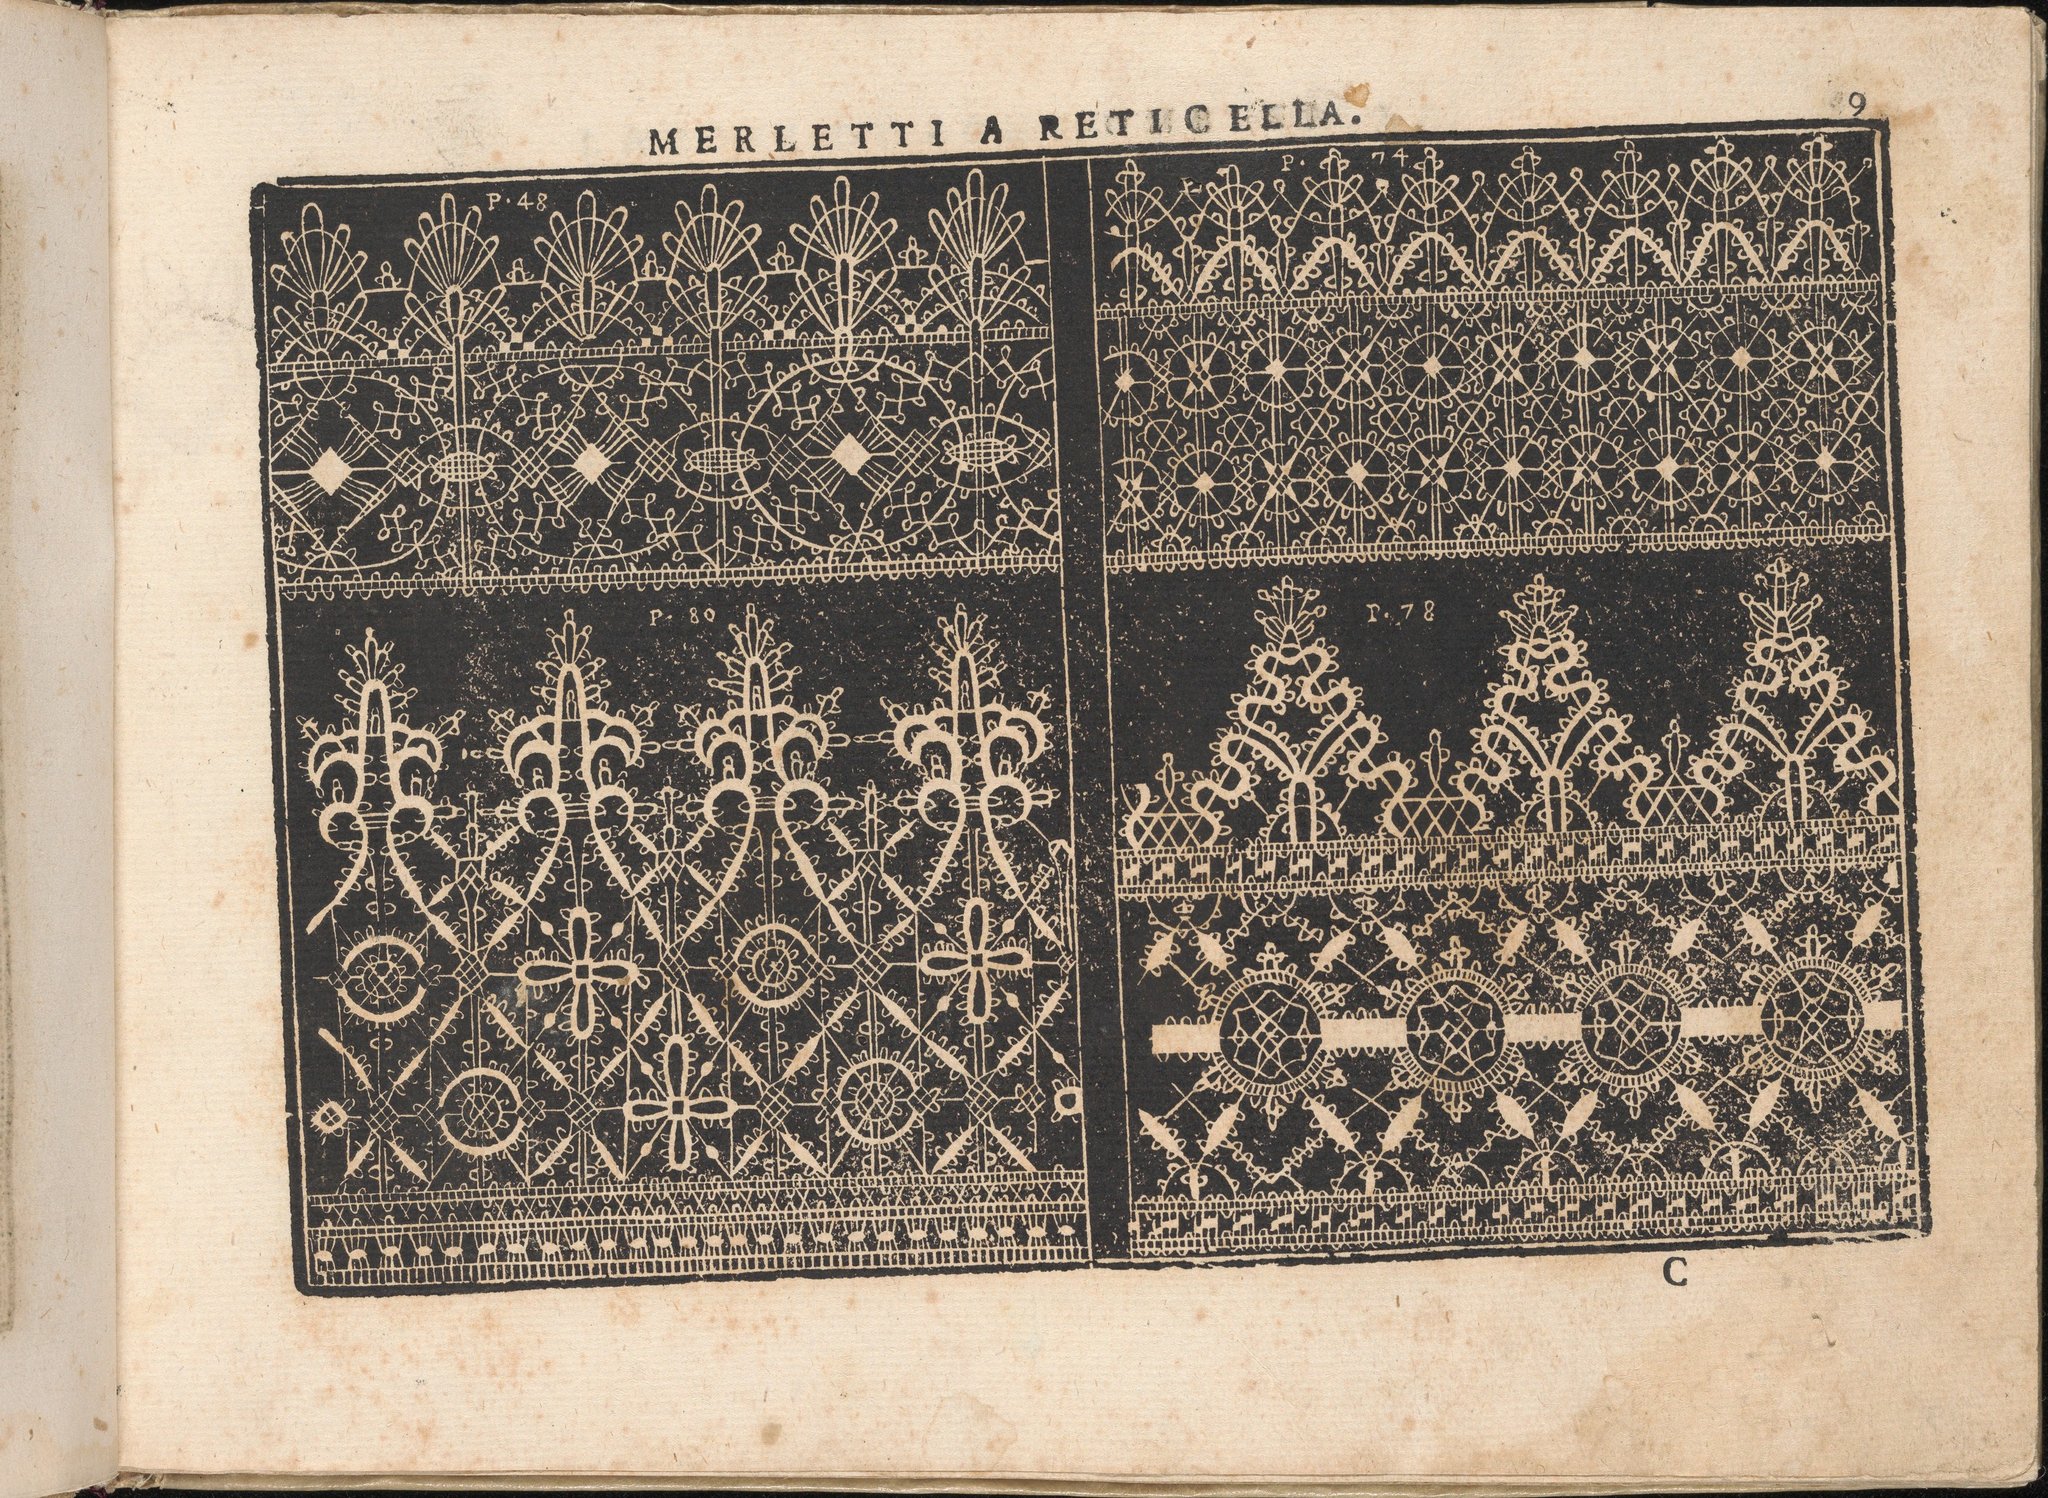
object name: book print ornament architecture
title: Fiore D'Ogni Virtu Per le Nobili Et Honeste Matrone, page 9 (recto)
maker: isabella catanea parasole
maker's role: designer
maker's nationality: italian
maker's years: 1565-1625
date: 1610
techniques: woodcut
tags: ornament